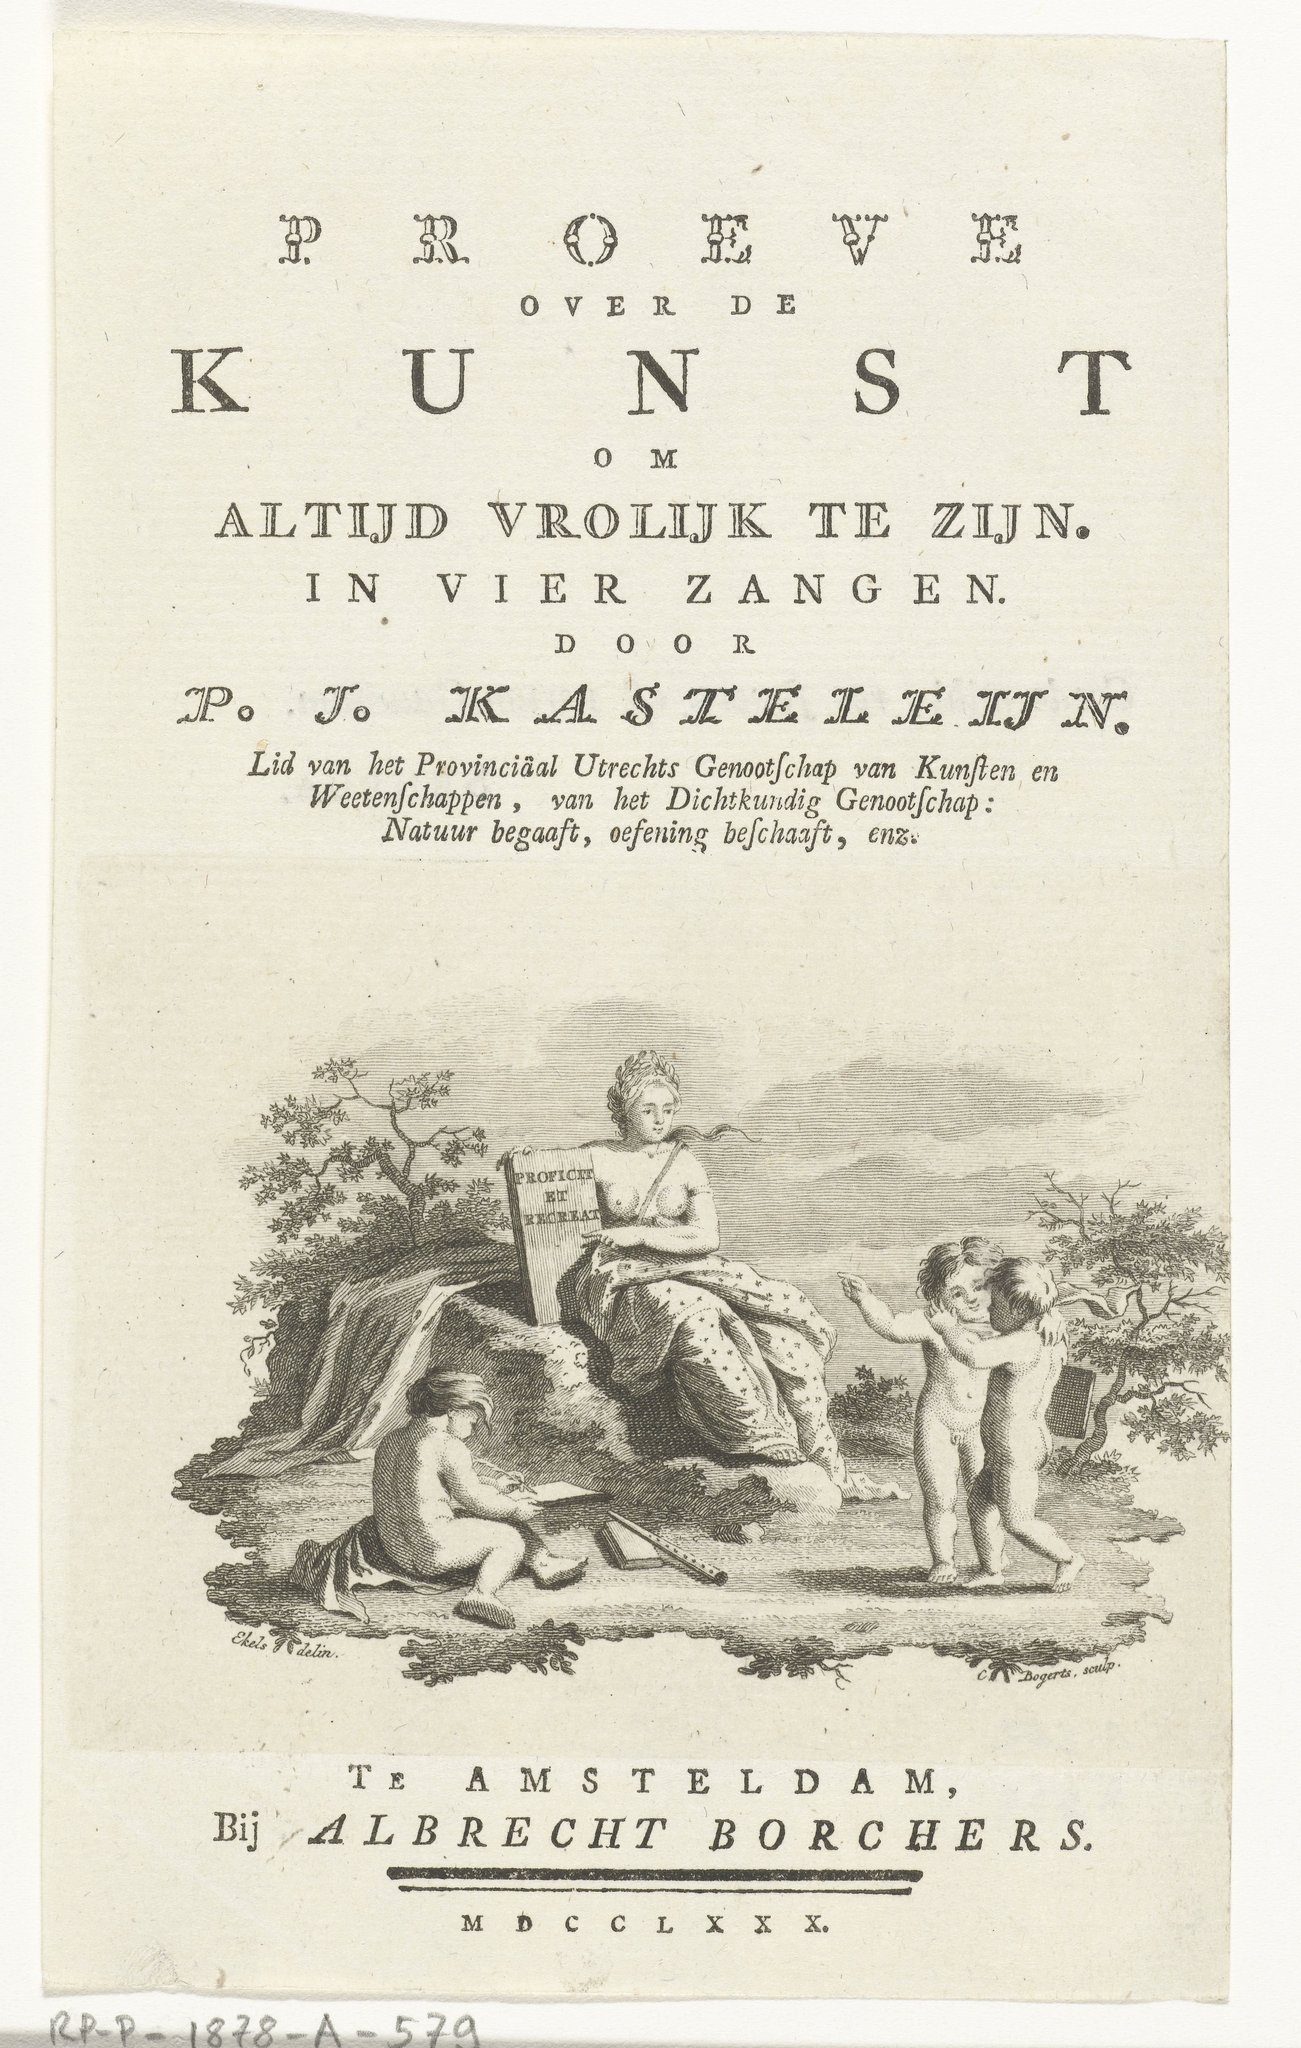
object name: titelblad, titelpagina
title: Titelpagina voor: P.J. Kasteleijn, Proeve over de kunst om altijd vrolijk te zijn. In vier zangen. Amsterdam, 1780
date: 1780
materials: paper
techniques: etching, letterpress printing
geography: amsterdam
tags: happiness, felicity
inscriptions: collector's mark: Lugt 2228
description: Titelpagina voor: P.J. Kasteleijn, Proeve over de kunst om altijd vrolijk te zijn. In vier zangen. Amsterdam, A. Borchers, 1780 (colofon: gedrukt bij J.F. Rosart)